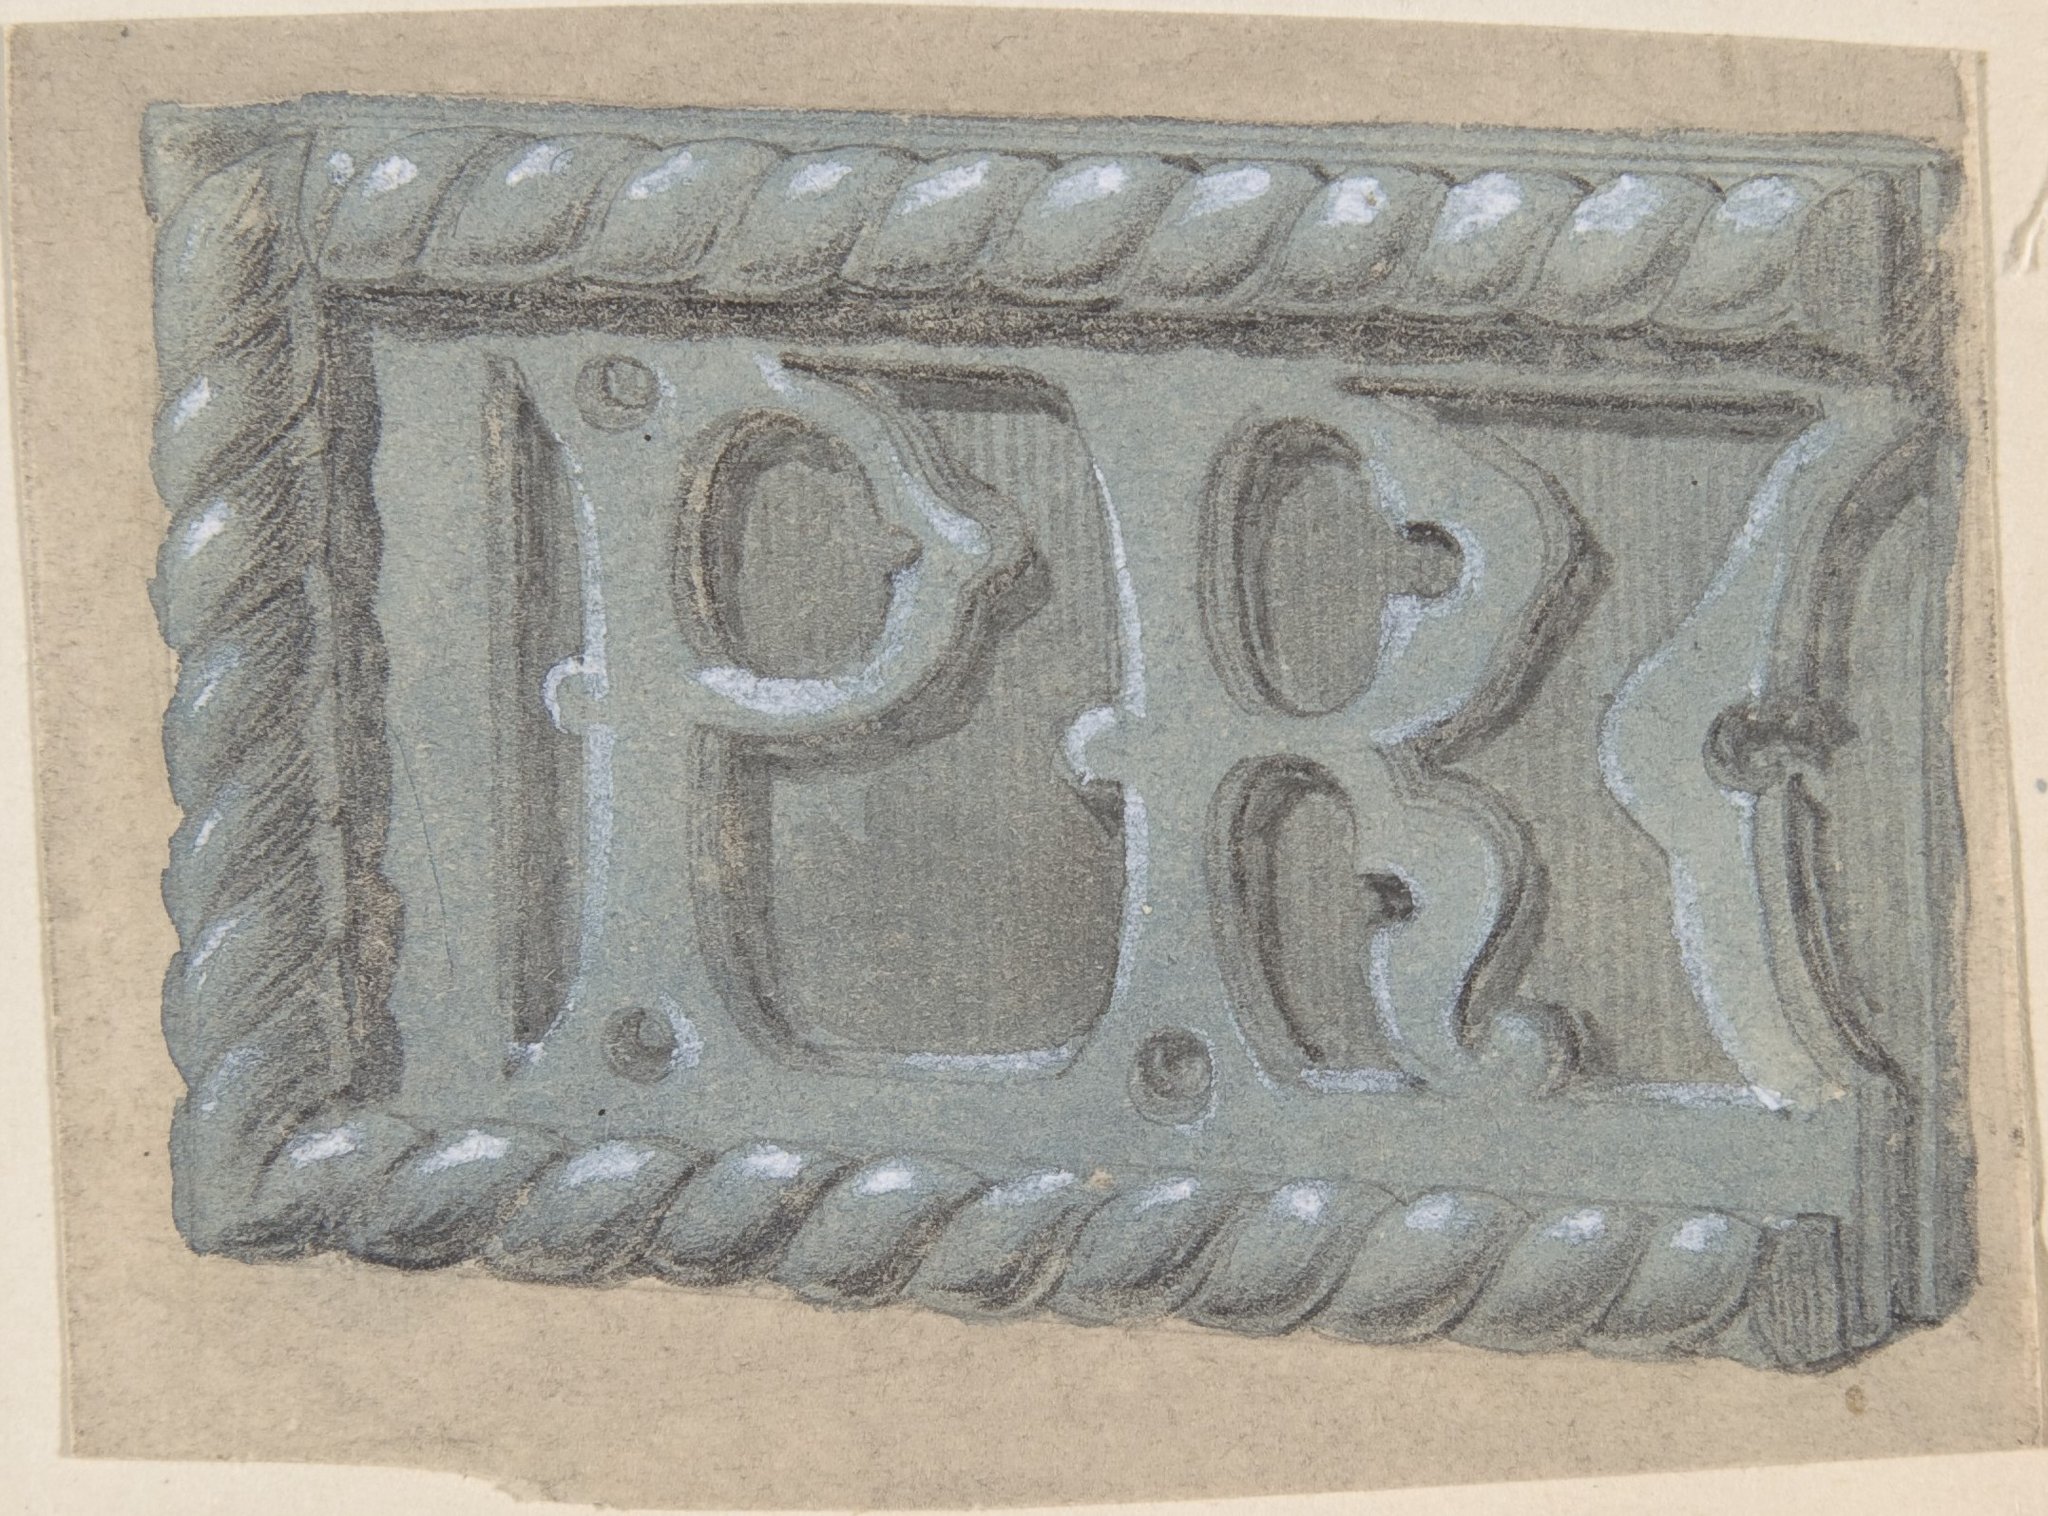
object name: drawing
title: Metal object, with initials "PR", for a church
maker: anonymous, british, 19th century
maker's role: artist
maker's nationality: british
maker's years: 1800-1900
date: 1851-1900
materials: gouache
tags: insignia